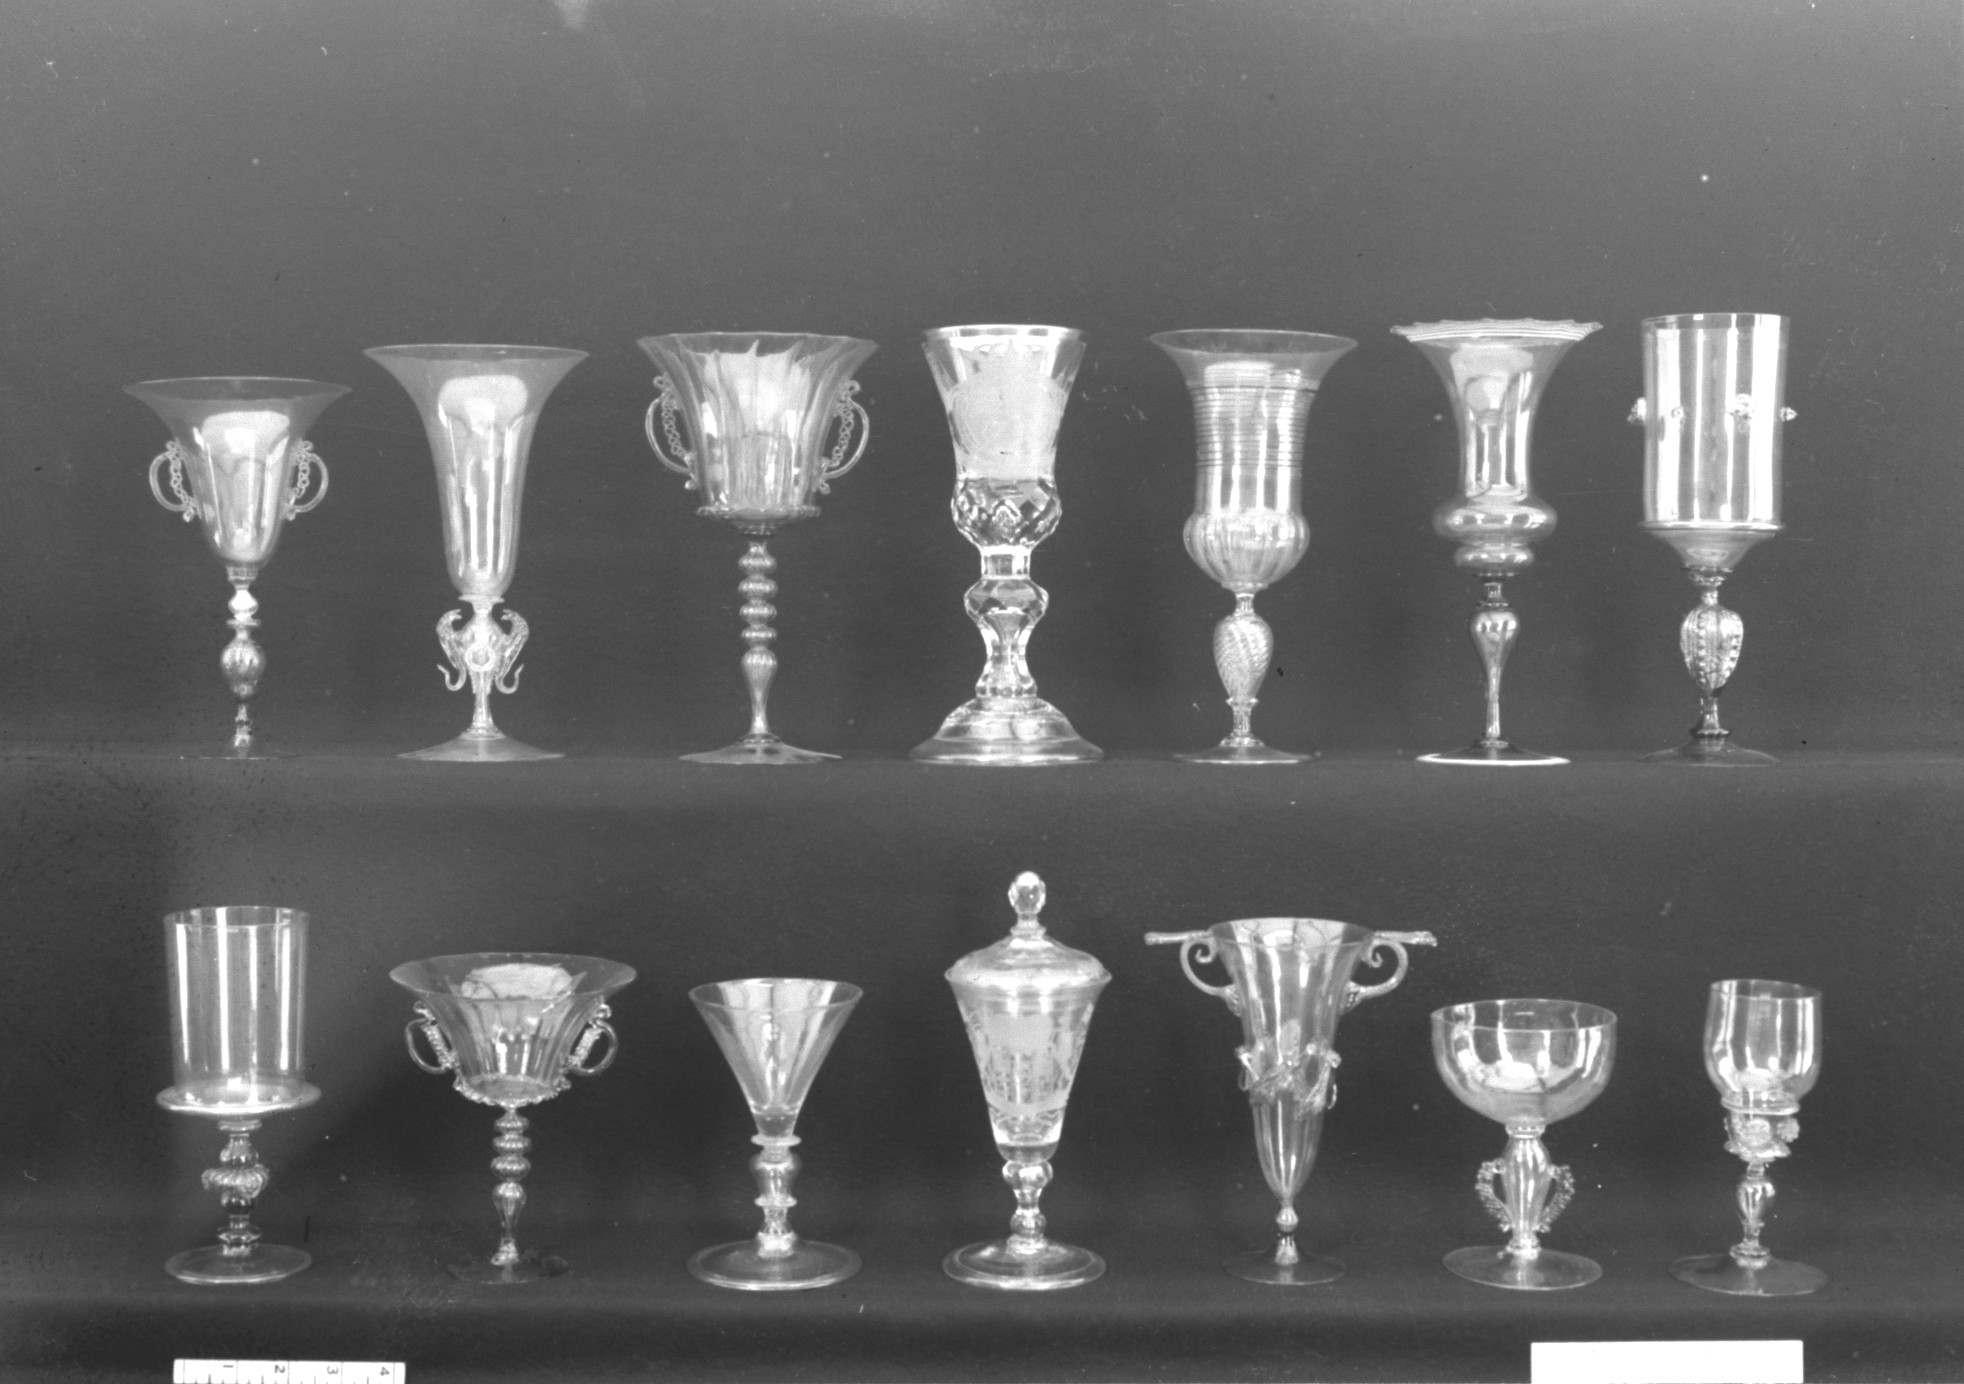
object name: goblet or reliquary jar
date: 1601-1700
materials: glass